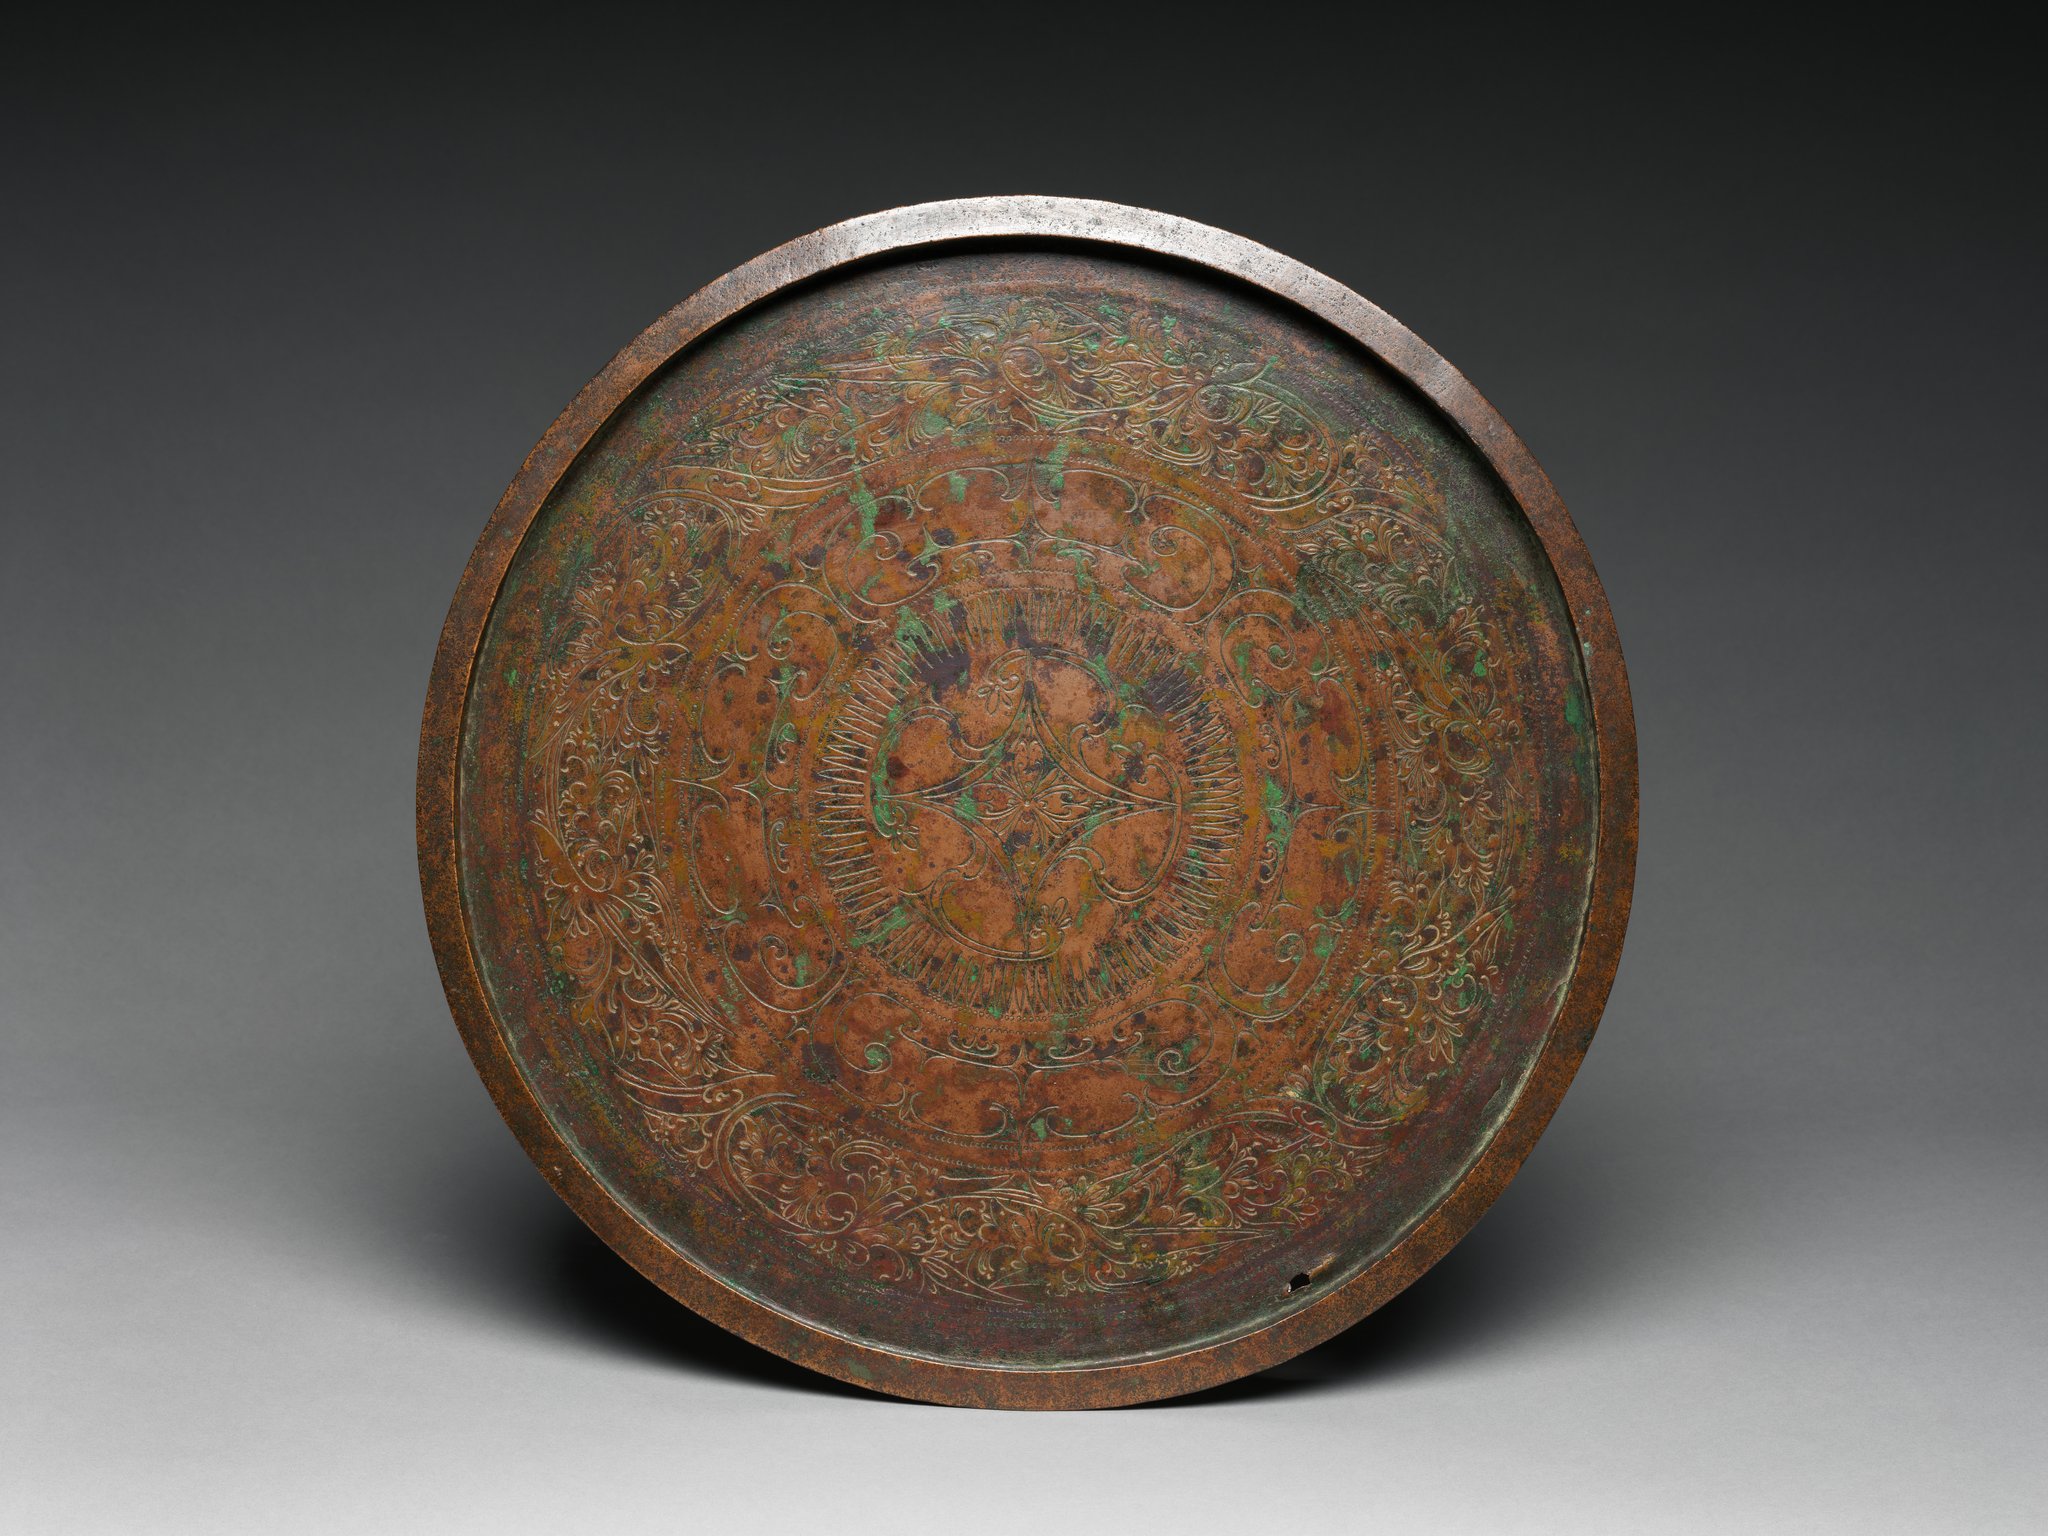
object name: tray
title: Offering tray (talam)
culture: indonesian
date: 1101-1400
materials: copper alloy